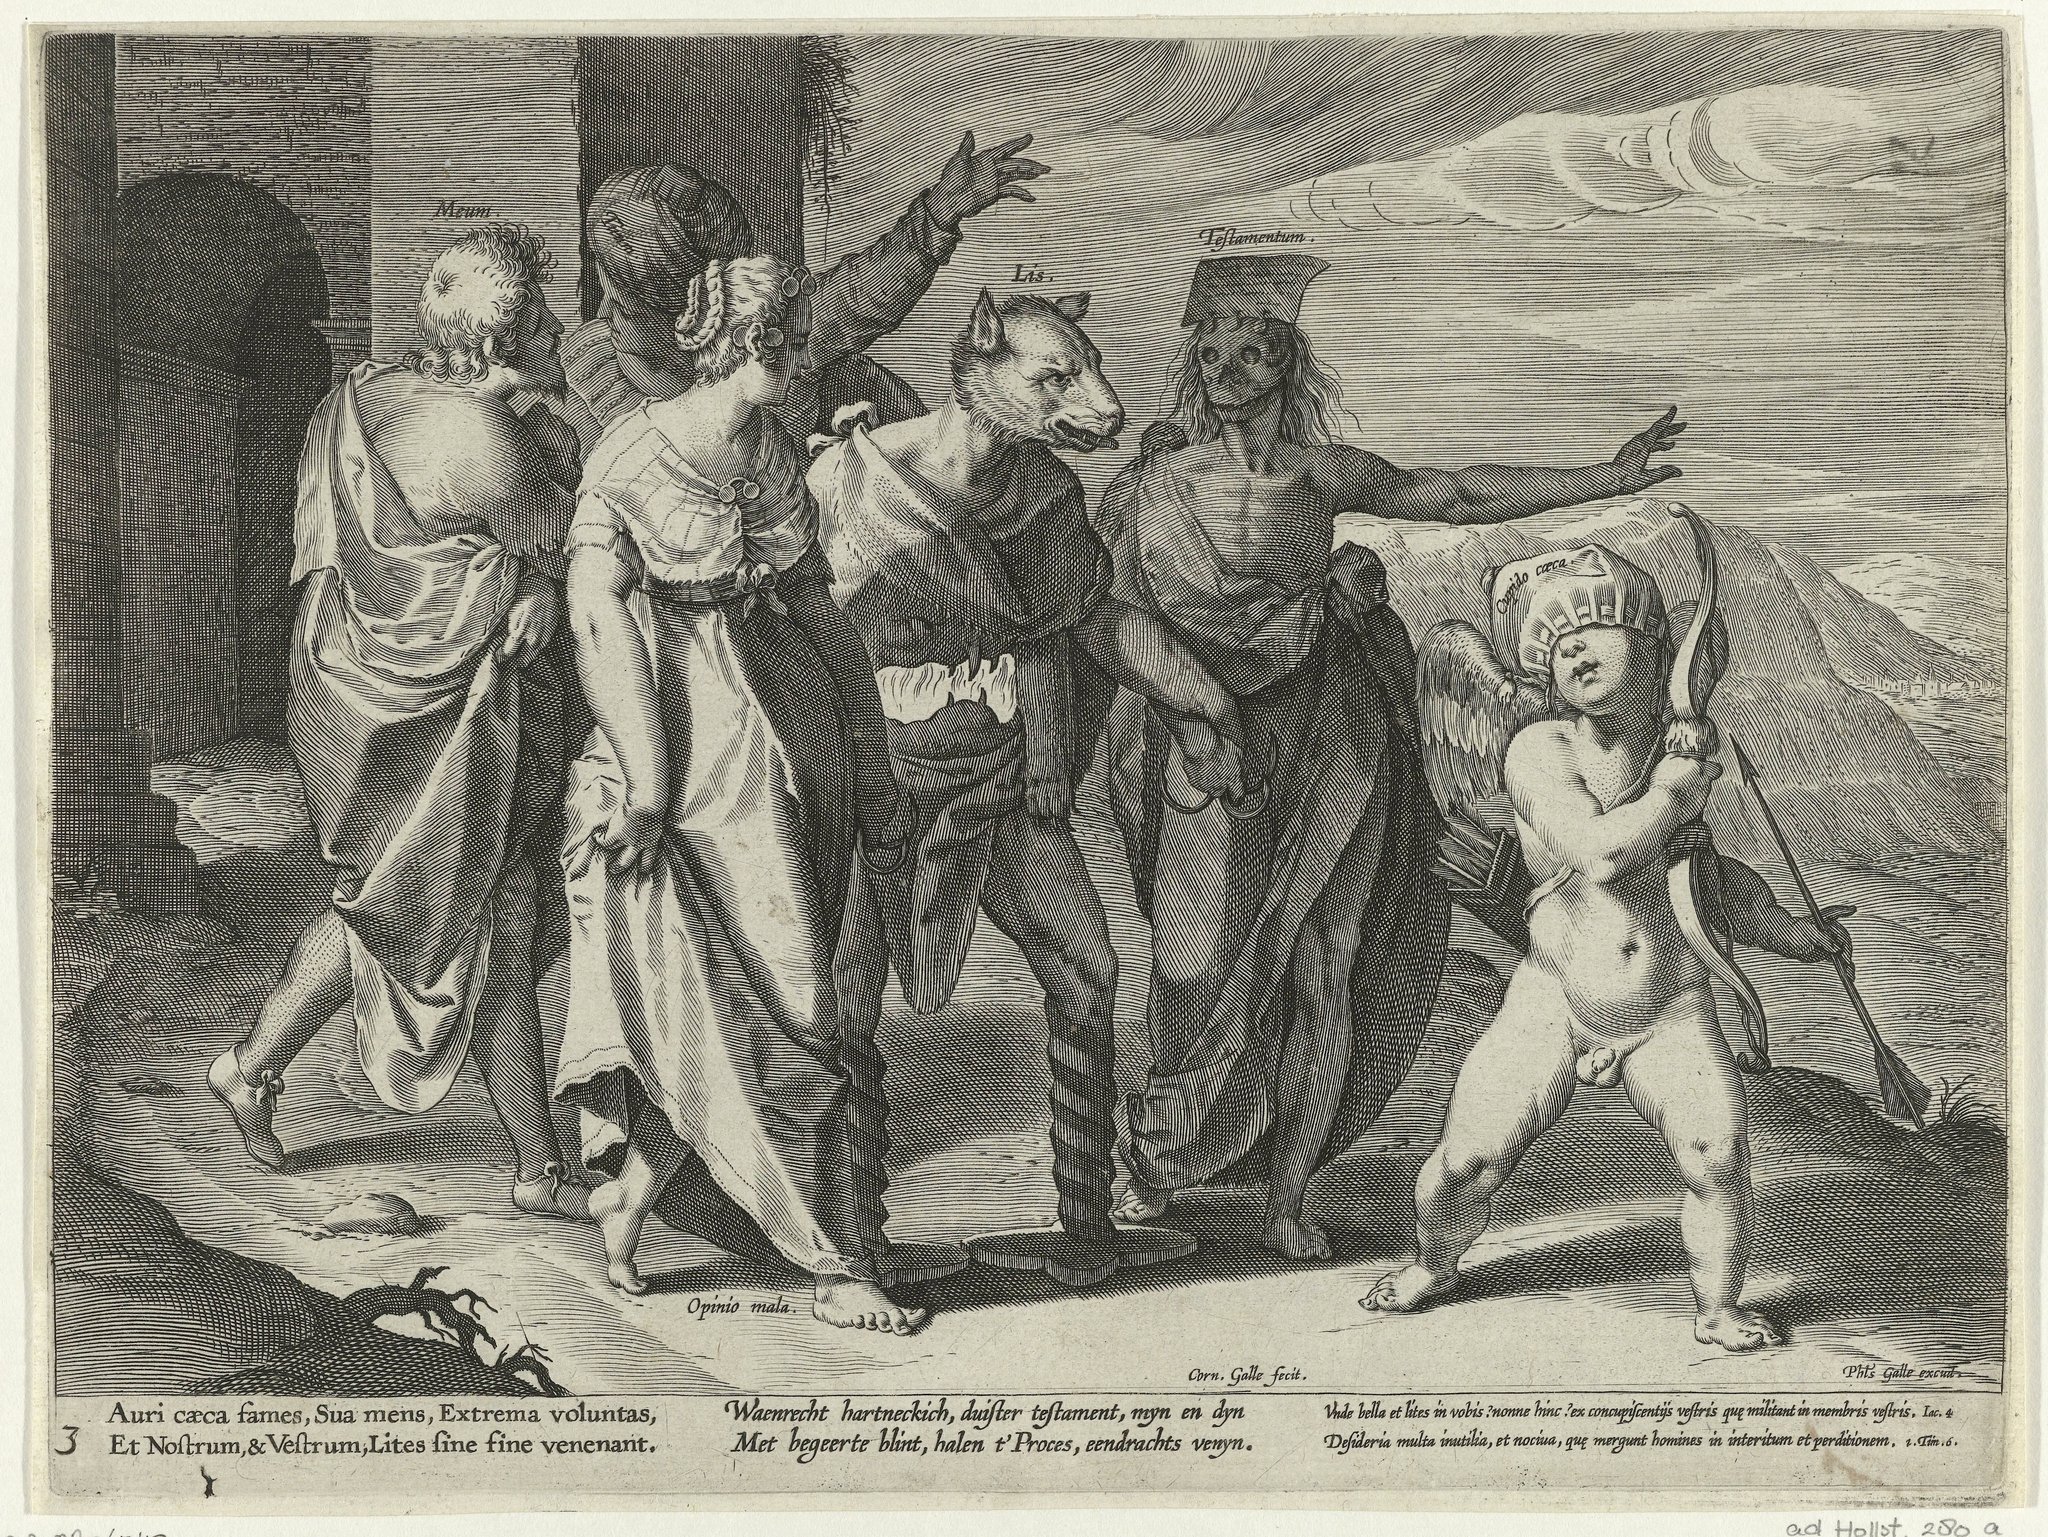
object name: print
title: Misbruik van het erfrecht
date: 1593-1597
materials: paper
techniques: engraving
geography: antwerp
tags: greed, covetousness, cupidity; 'cupidità' (ripa), (story of) cupid, amor (eros), blind, blindness - aa - metaphorically blind, tort; legal abuse; judicial murder (+ abuse of legal power), opinion (+ abstract concept represented by female figure), making a testament (+ variant)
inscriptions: collector's mark: Lugt 240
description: De personificatie Procesvorming (Lis), een man met een wolvenkop, een hellemond als buik en schroeven als poten, wordt vergezeld door de personificaties Slechte Mening (Opinio Mala) en Nalatenschap (Testamentum). Ze volgen Blinde Begeerte (Cupido caeca) die door een geldzak over zijn hoofd verblind is. Achter Procesvorming wandelen de personificaties Mijn en Dijn. De prent heeft drie onderschriften (twee in het Latijn en een in het Nederlands) en maakt deel uit van een achtdelige serie over de misbruiken in procesvoering.